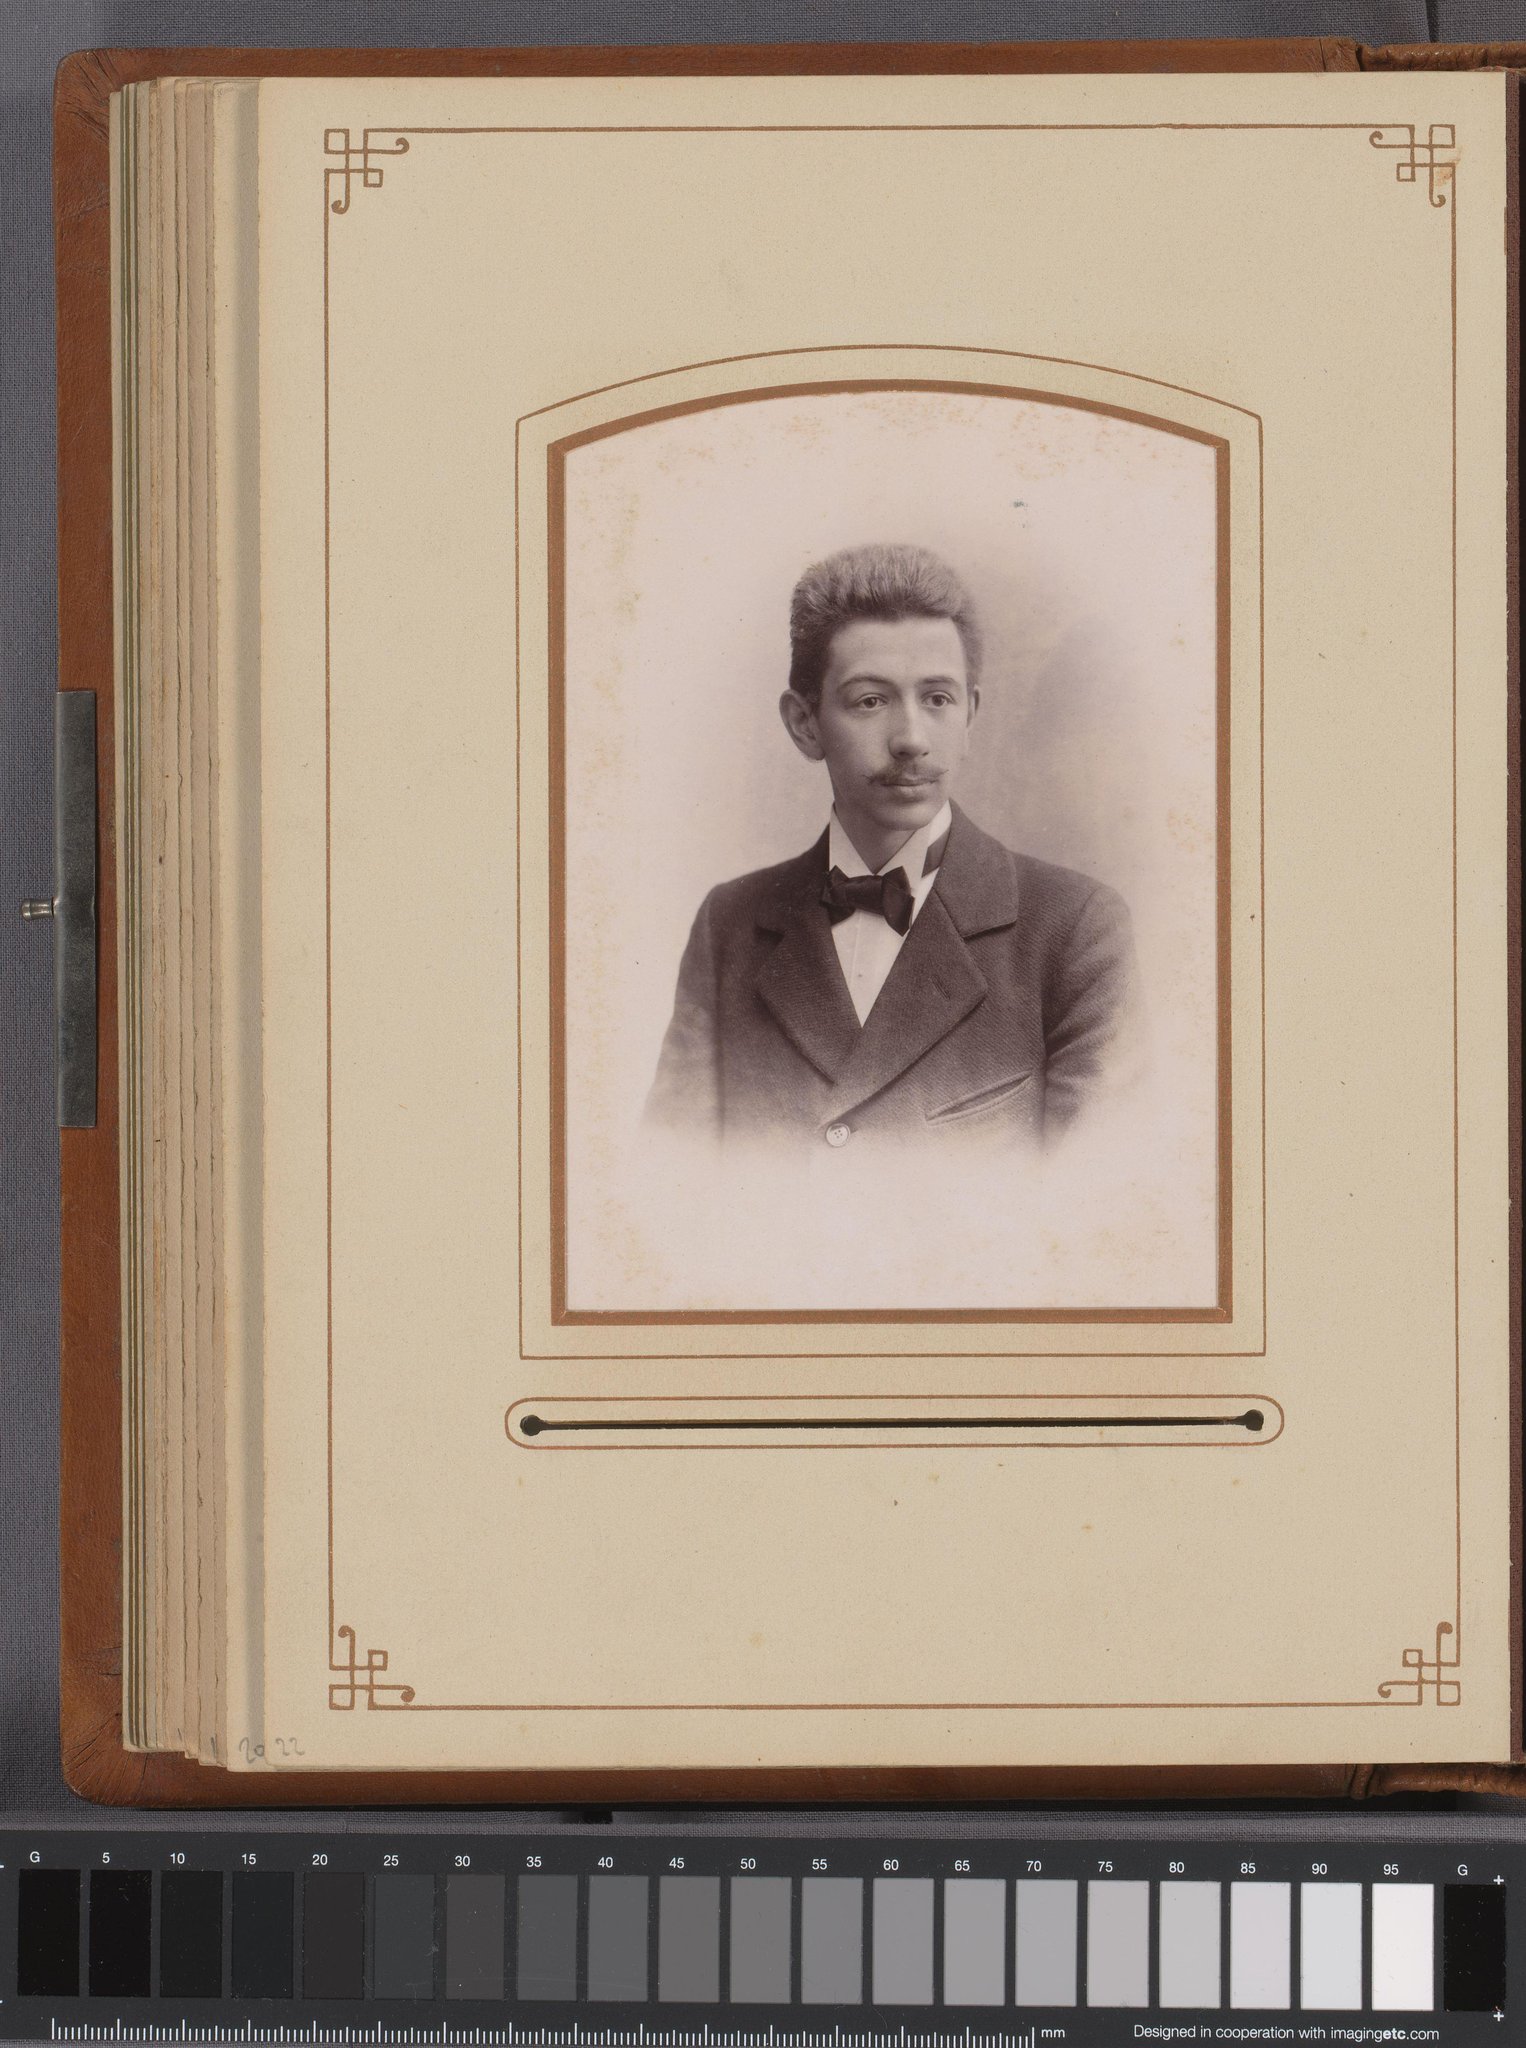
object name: album leaf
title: Portret van een man met snor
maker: jos. raab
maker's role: fotograaf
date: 1870-1900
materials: cardboard, photographic support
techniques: albumen print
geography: braunschweig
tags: moustache, historical persons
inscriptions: inscription: ‘Jos. Raab/ Atelier für Portraitphotographie/ u. Vergrösserungen/ Braunschweig/ Steinweg 42’